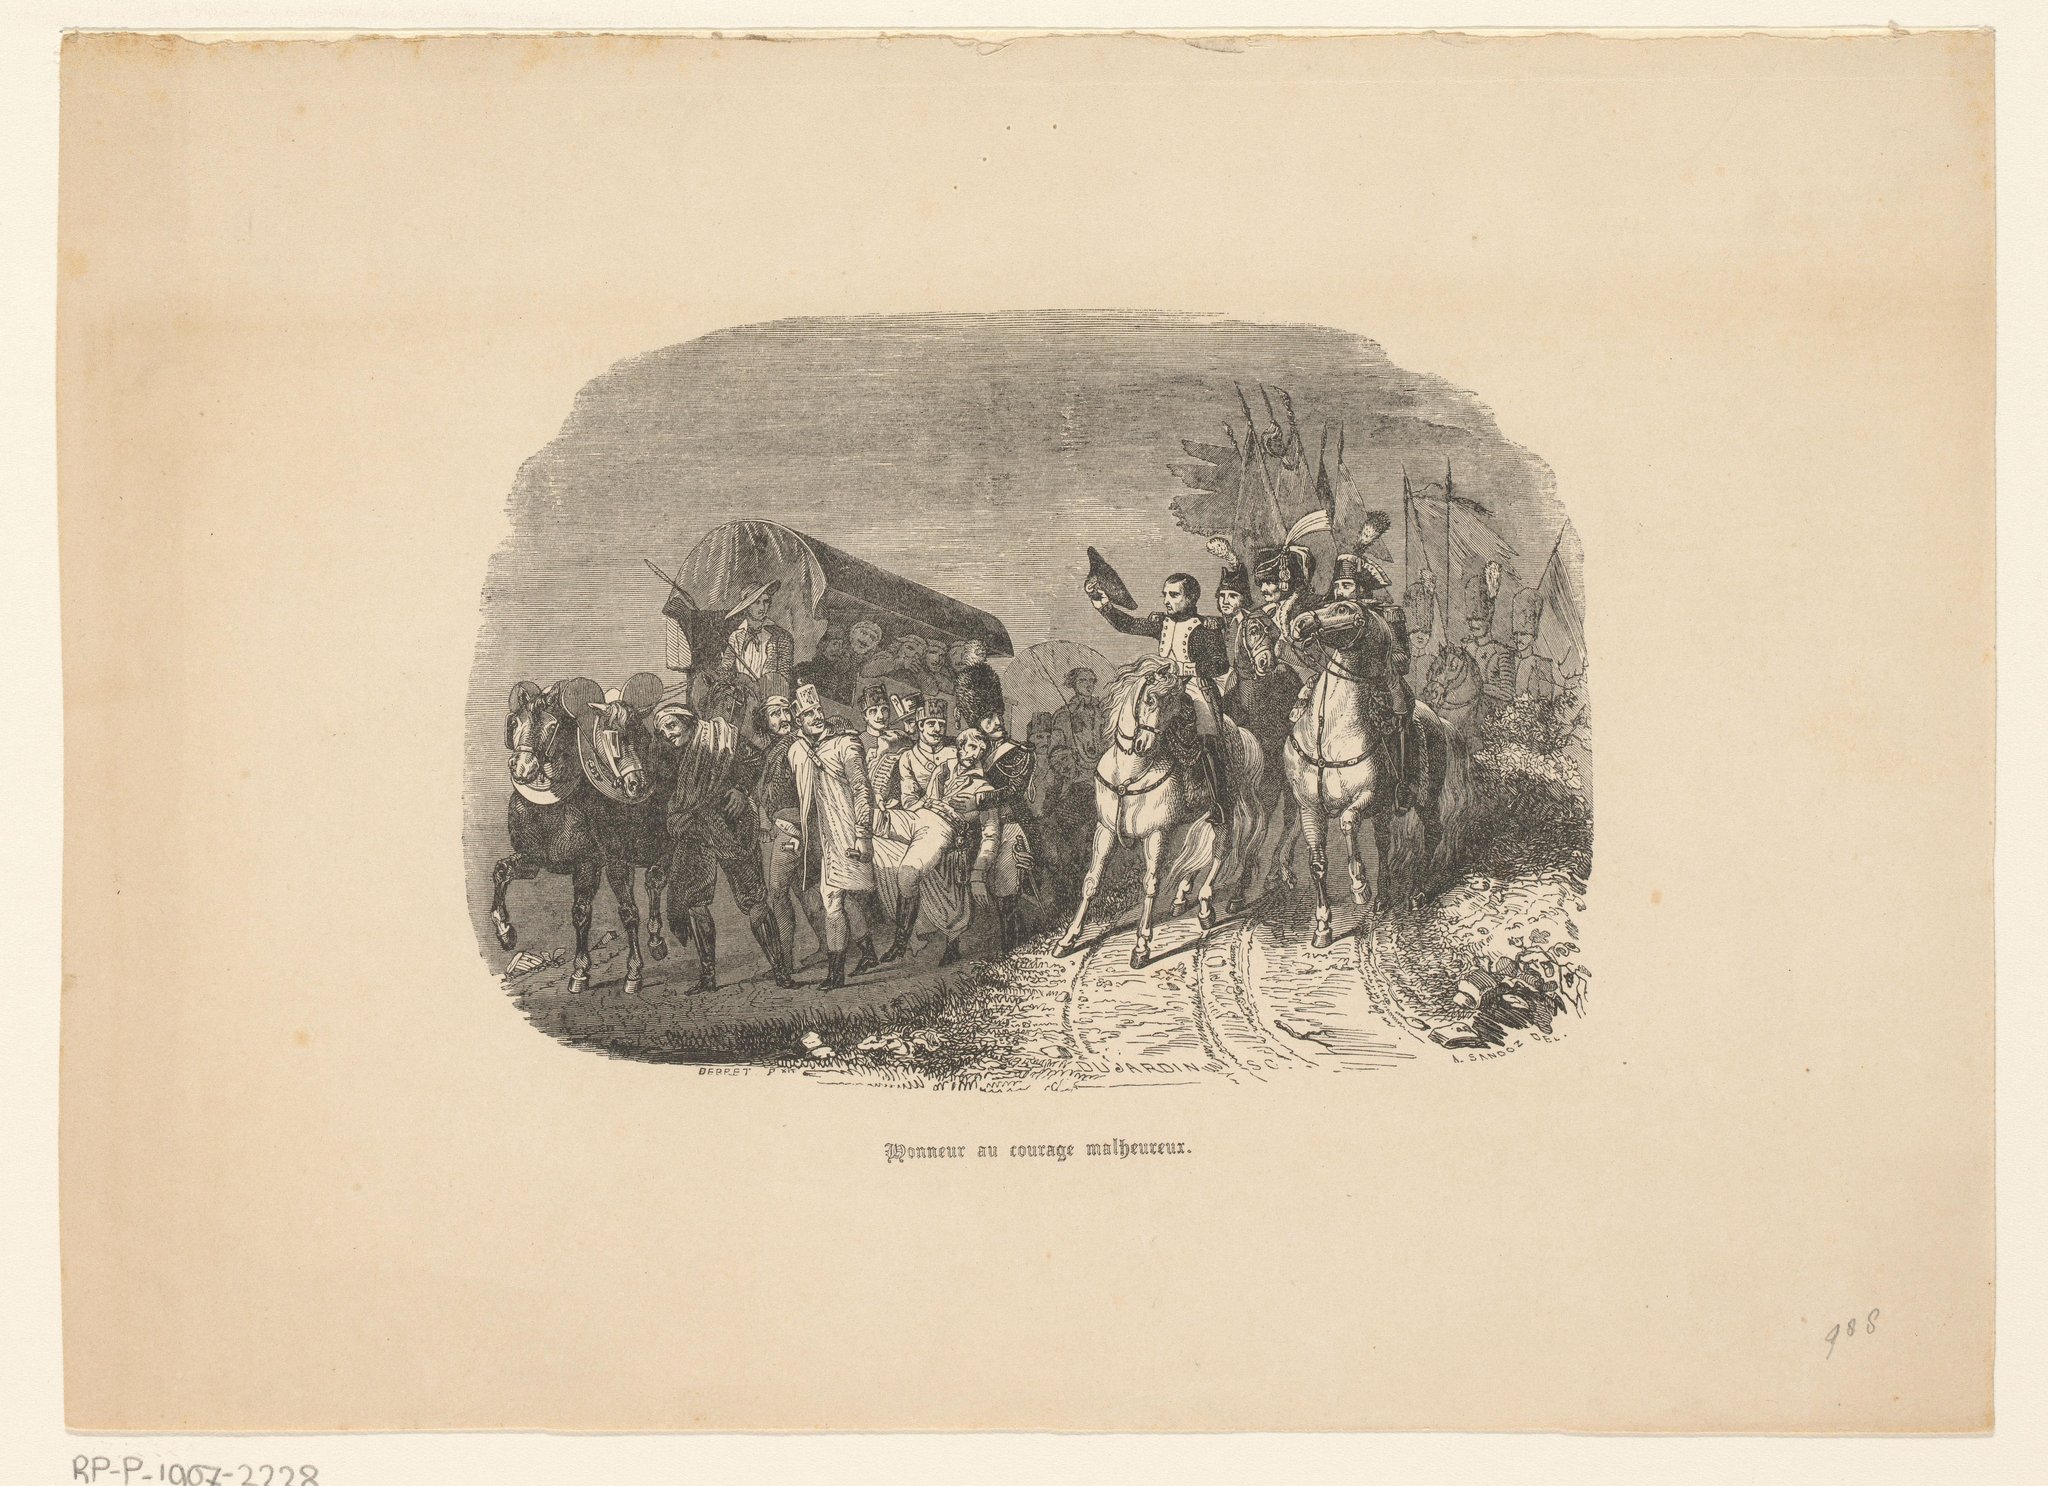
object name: print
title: Napoleon betoont respect aan een gewonde soldaat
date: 1818-1859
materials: paper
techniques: engraving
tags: napoleon i (emperor of the french), transport of the sick, wounded and dead by vehicle, historical persons, disabled soldier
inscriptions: collector's mark: Lugt 2228